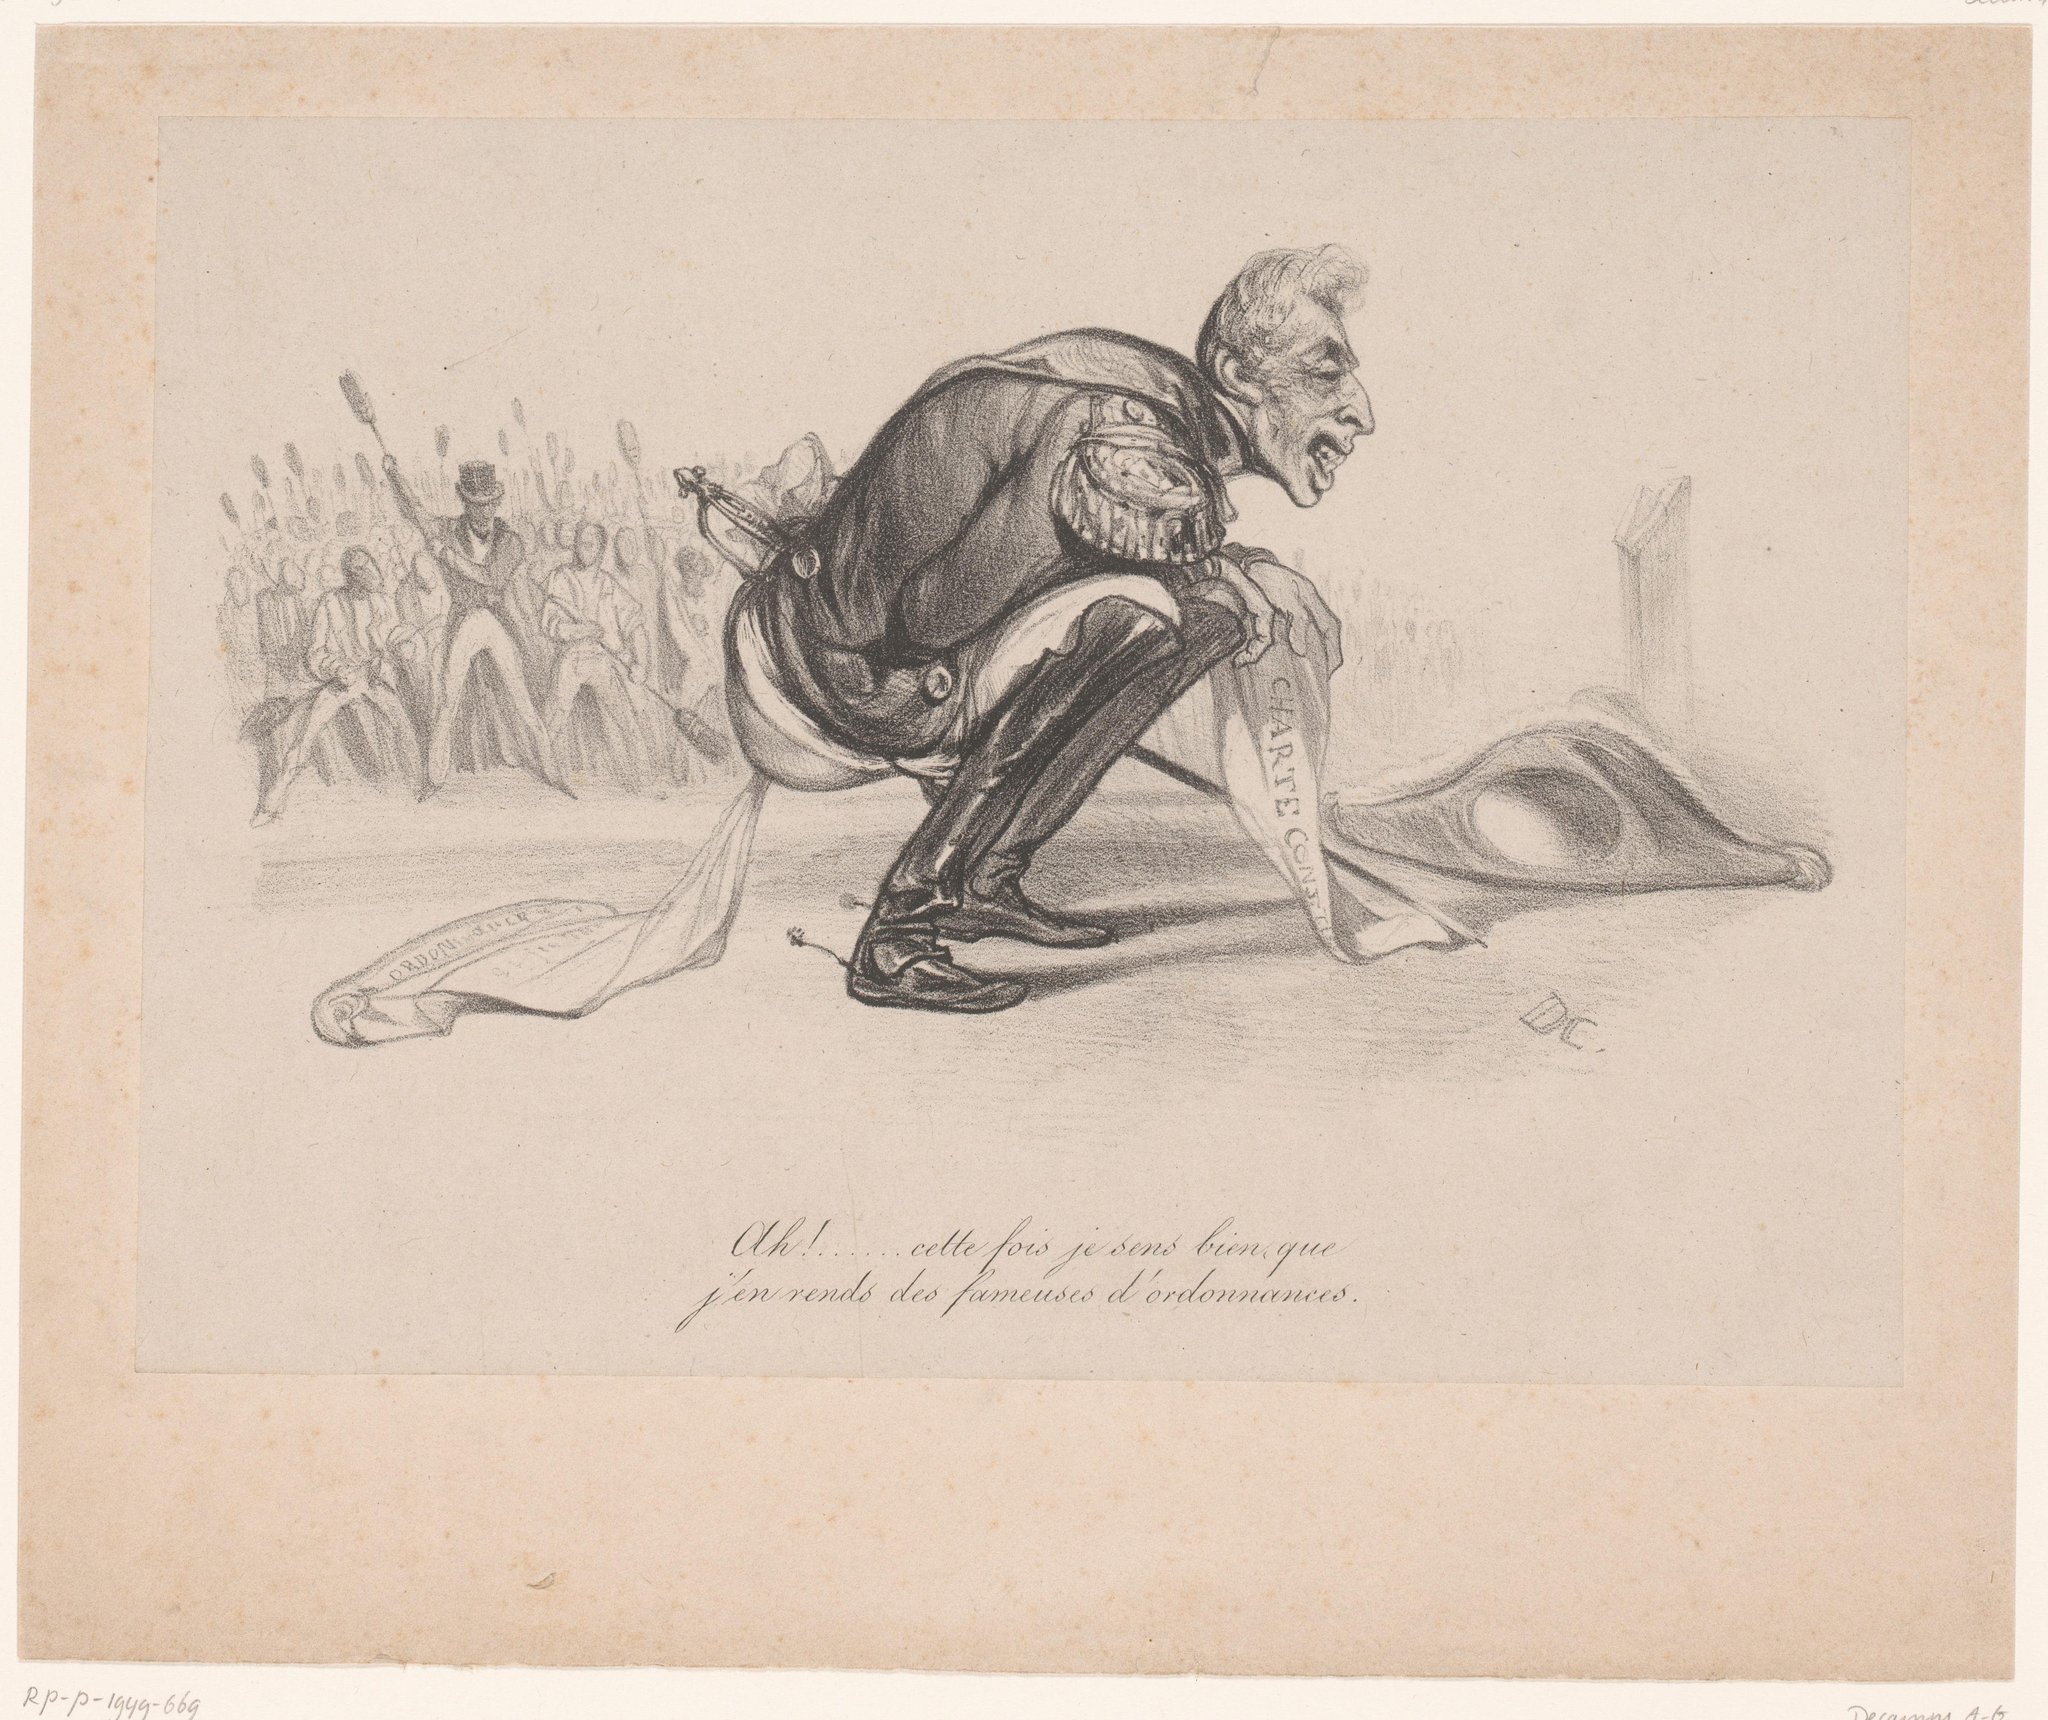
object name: cartoon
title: Karel X van Frankrijk produceert de Juli Ordonnanties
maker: alexandre-gabriel decamps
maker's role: draughtsman, painter, print maker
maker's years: 1803-1860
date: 1830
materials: paper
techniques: lithograph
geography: paris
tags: historical persons, political caricatures and satires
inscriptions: collector's mark: Lugt 2760, collector's mark: Lugt 2228a